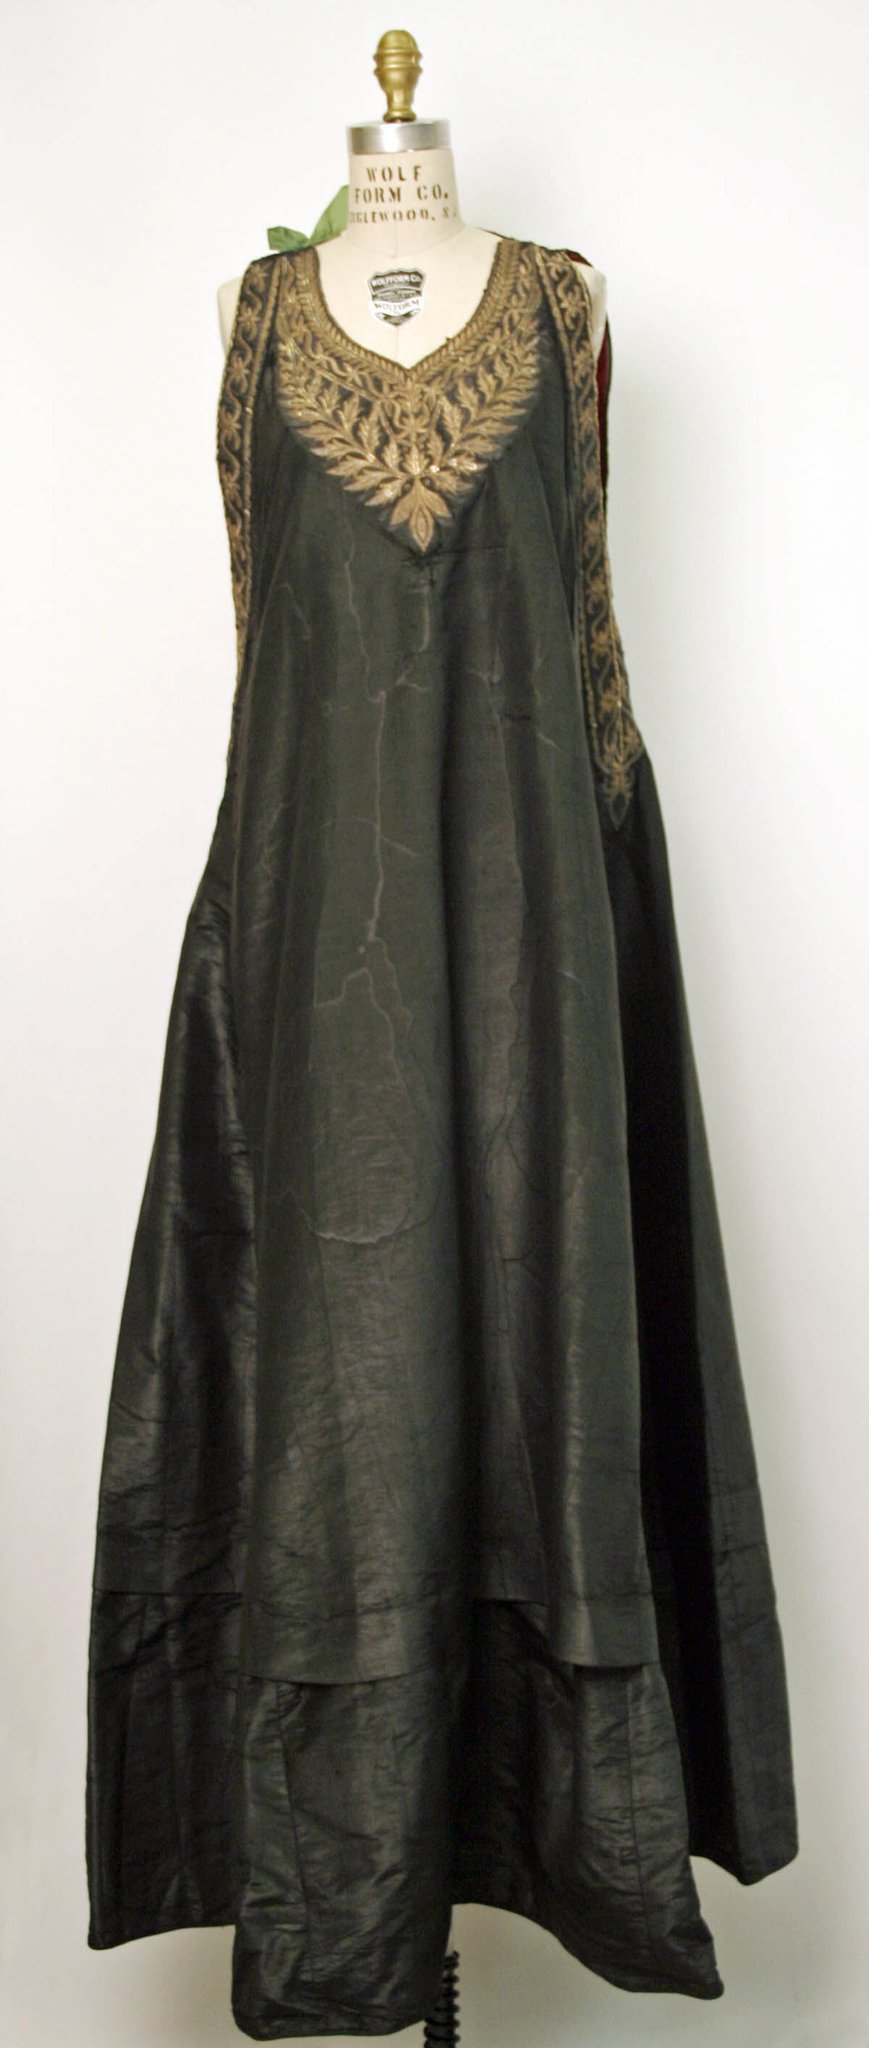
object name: dress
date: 1801-1900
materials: cotton, metal thread, silk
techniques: embroidery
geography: algeria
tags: dresses